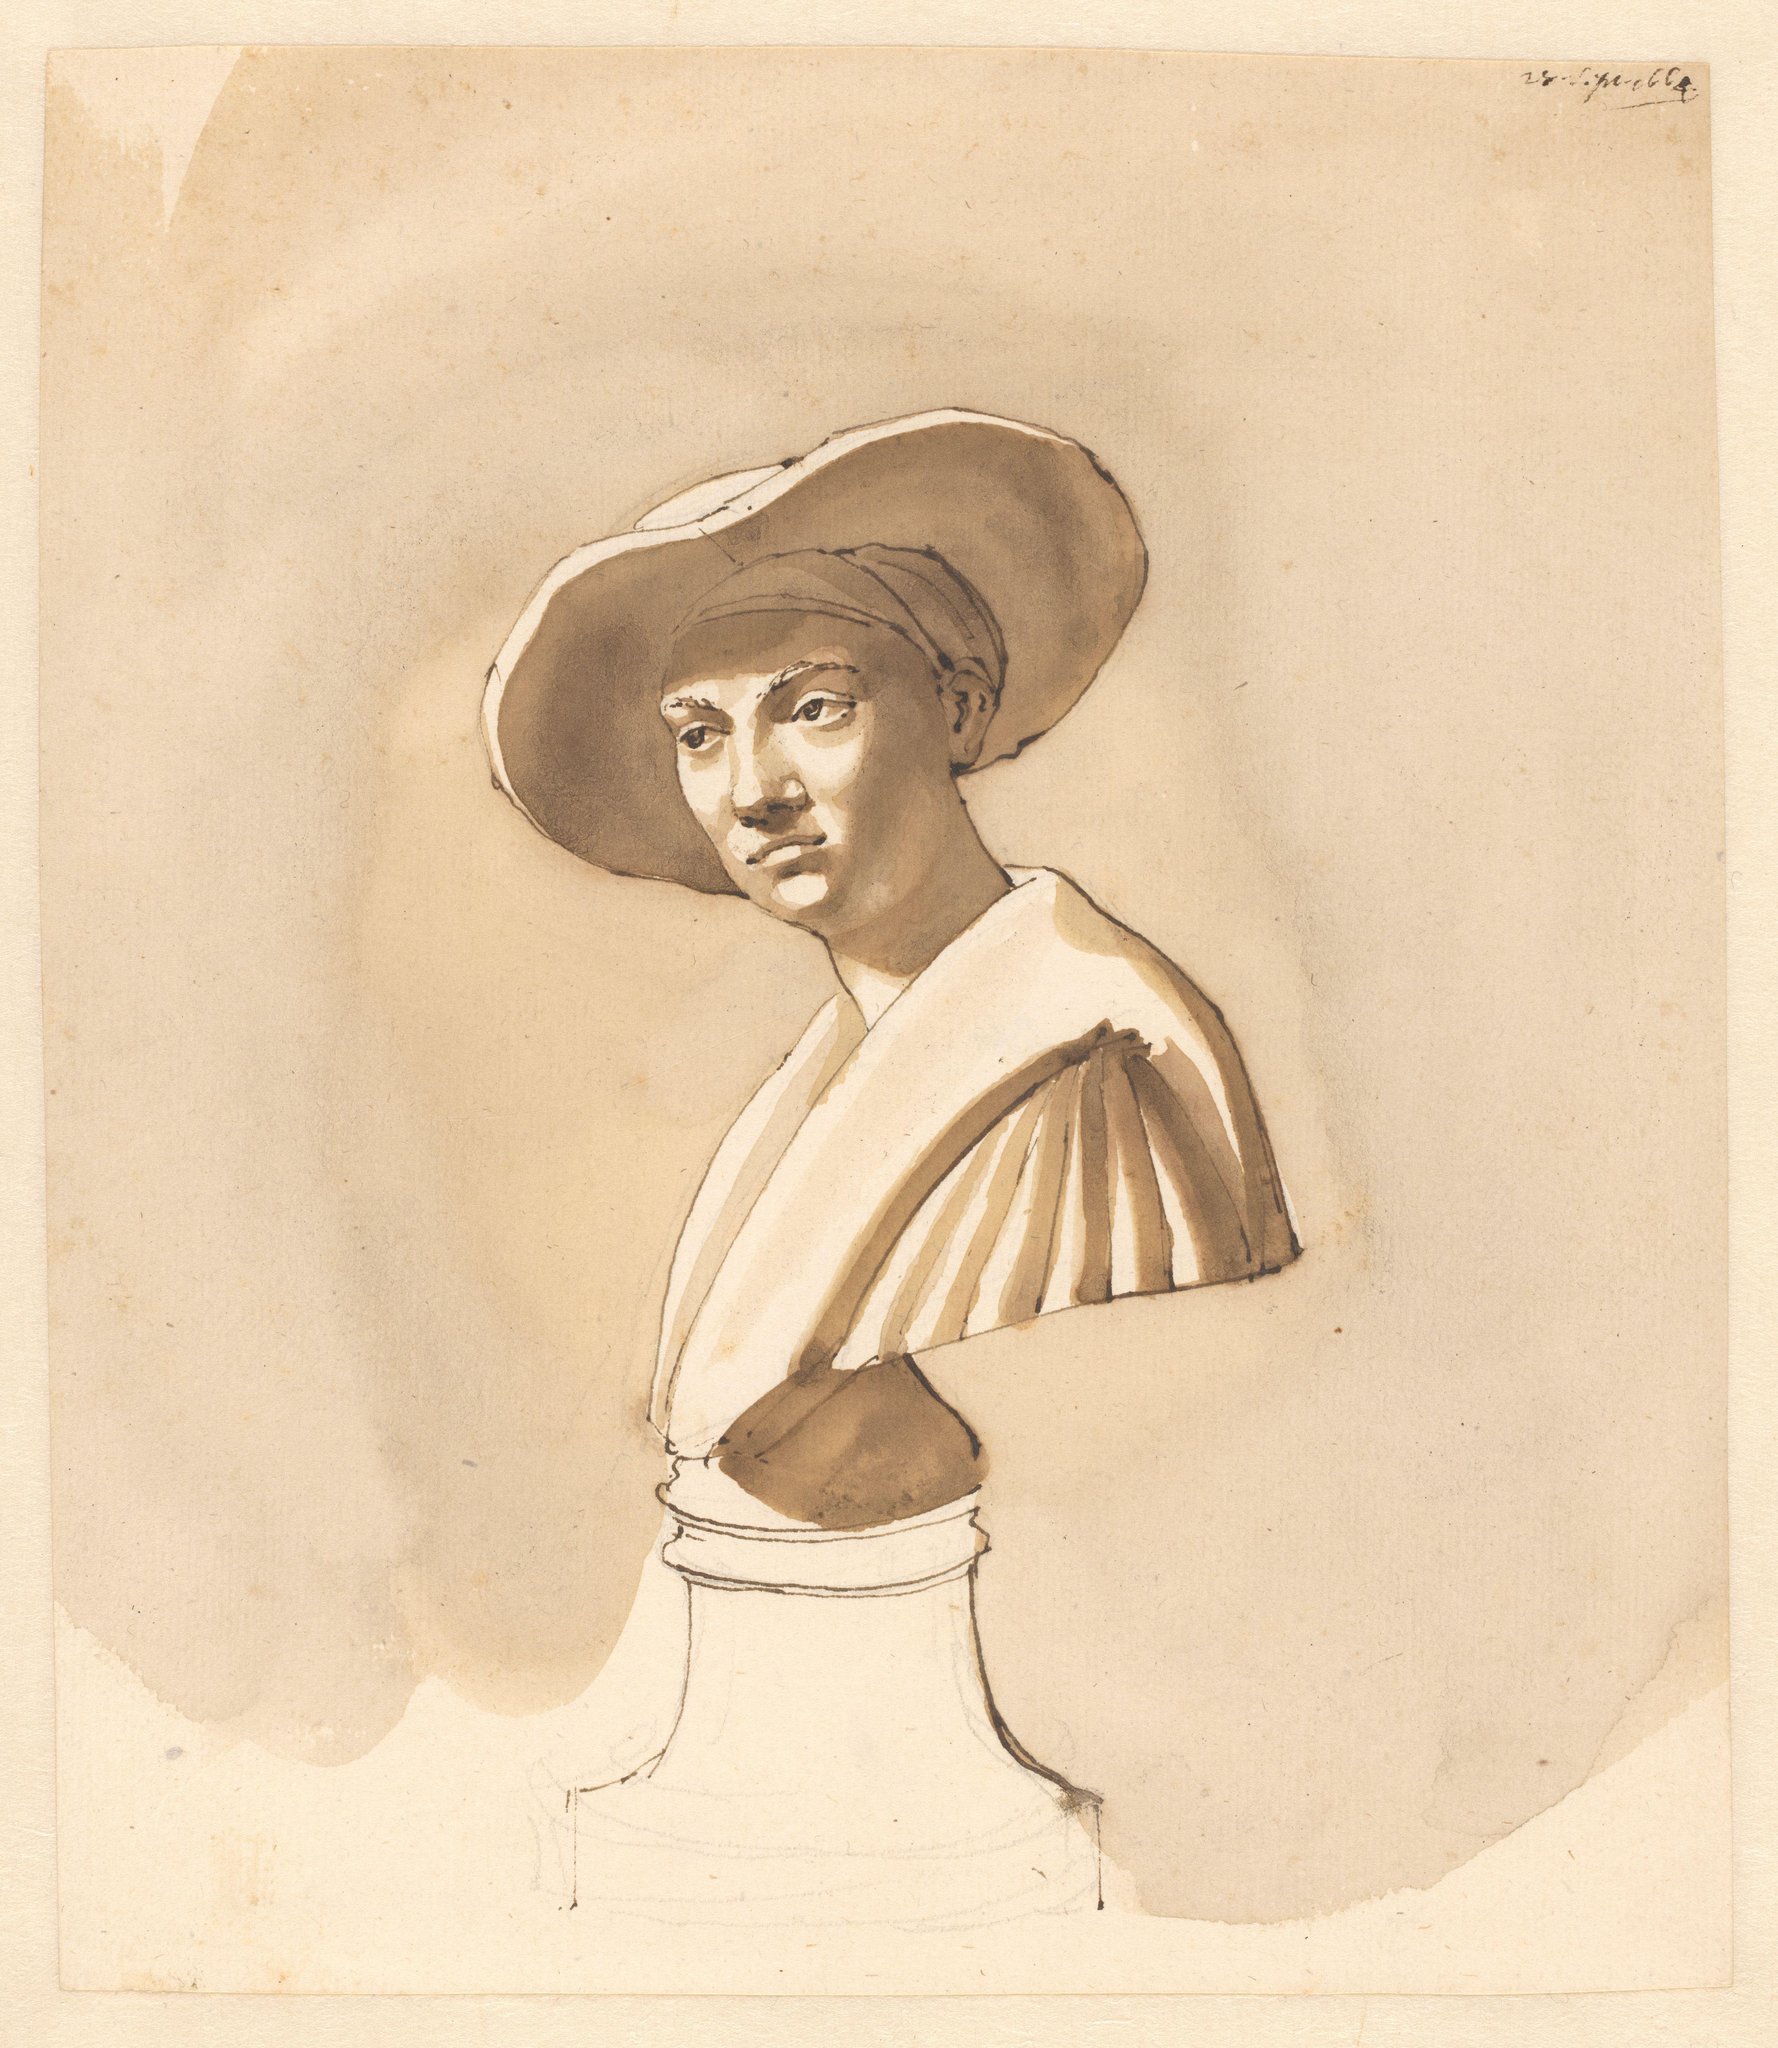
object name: drawing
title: Buste van Filibert van Savoye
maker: jan de bisschop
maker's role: draughtsman, print maker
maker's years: 1628-1671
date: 1664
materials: paper, pencil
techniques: brush, pen, wash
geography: the hague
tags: pont-d'ain, filibert ii van savoye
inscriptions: date: ‘28 Sept 1664’, date: ‘28 Sept 1664’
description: De afgebeelde buste is nog in twee versies bekend, beide in buxushout, en zonder het voetstuk en de schuine armafsnijding zoals in de tekening. Deze twee bevinden zich respectievelijk in het Bodemuseum Berlijn (inv.no. 818) en British Museum (Waddesdon Bequest, inv.nr. 261). Zie cat. Small Wonders, no. 71 voor het exemplaar uit het Bodemuseum. De tekening geeft dus een onbekend derde exemplaar weer, dat zich in 1664 in Nederland bevond.